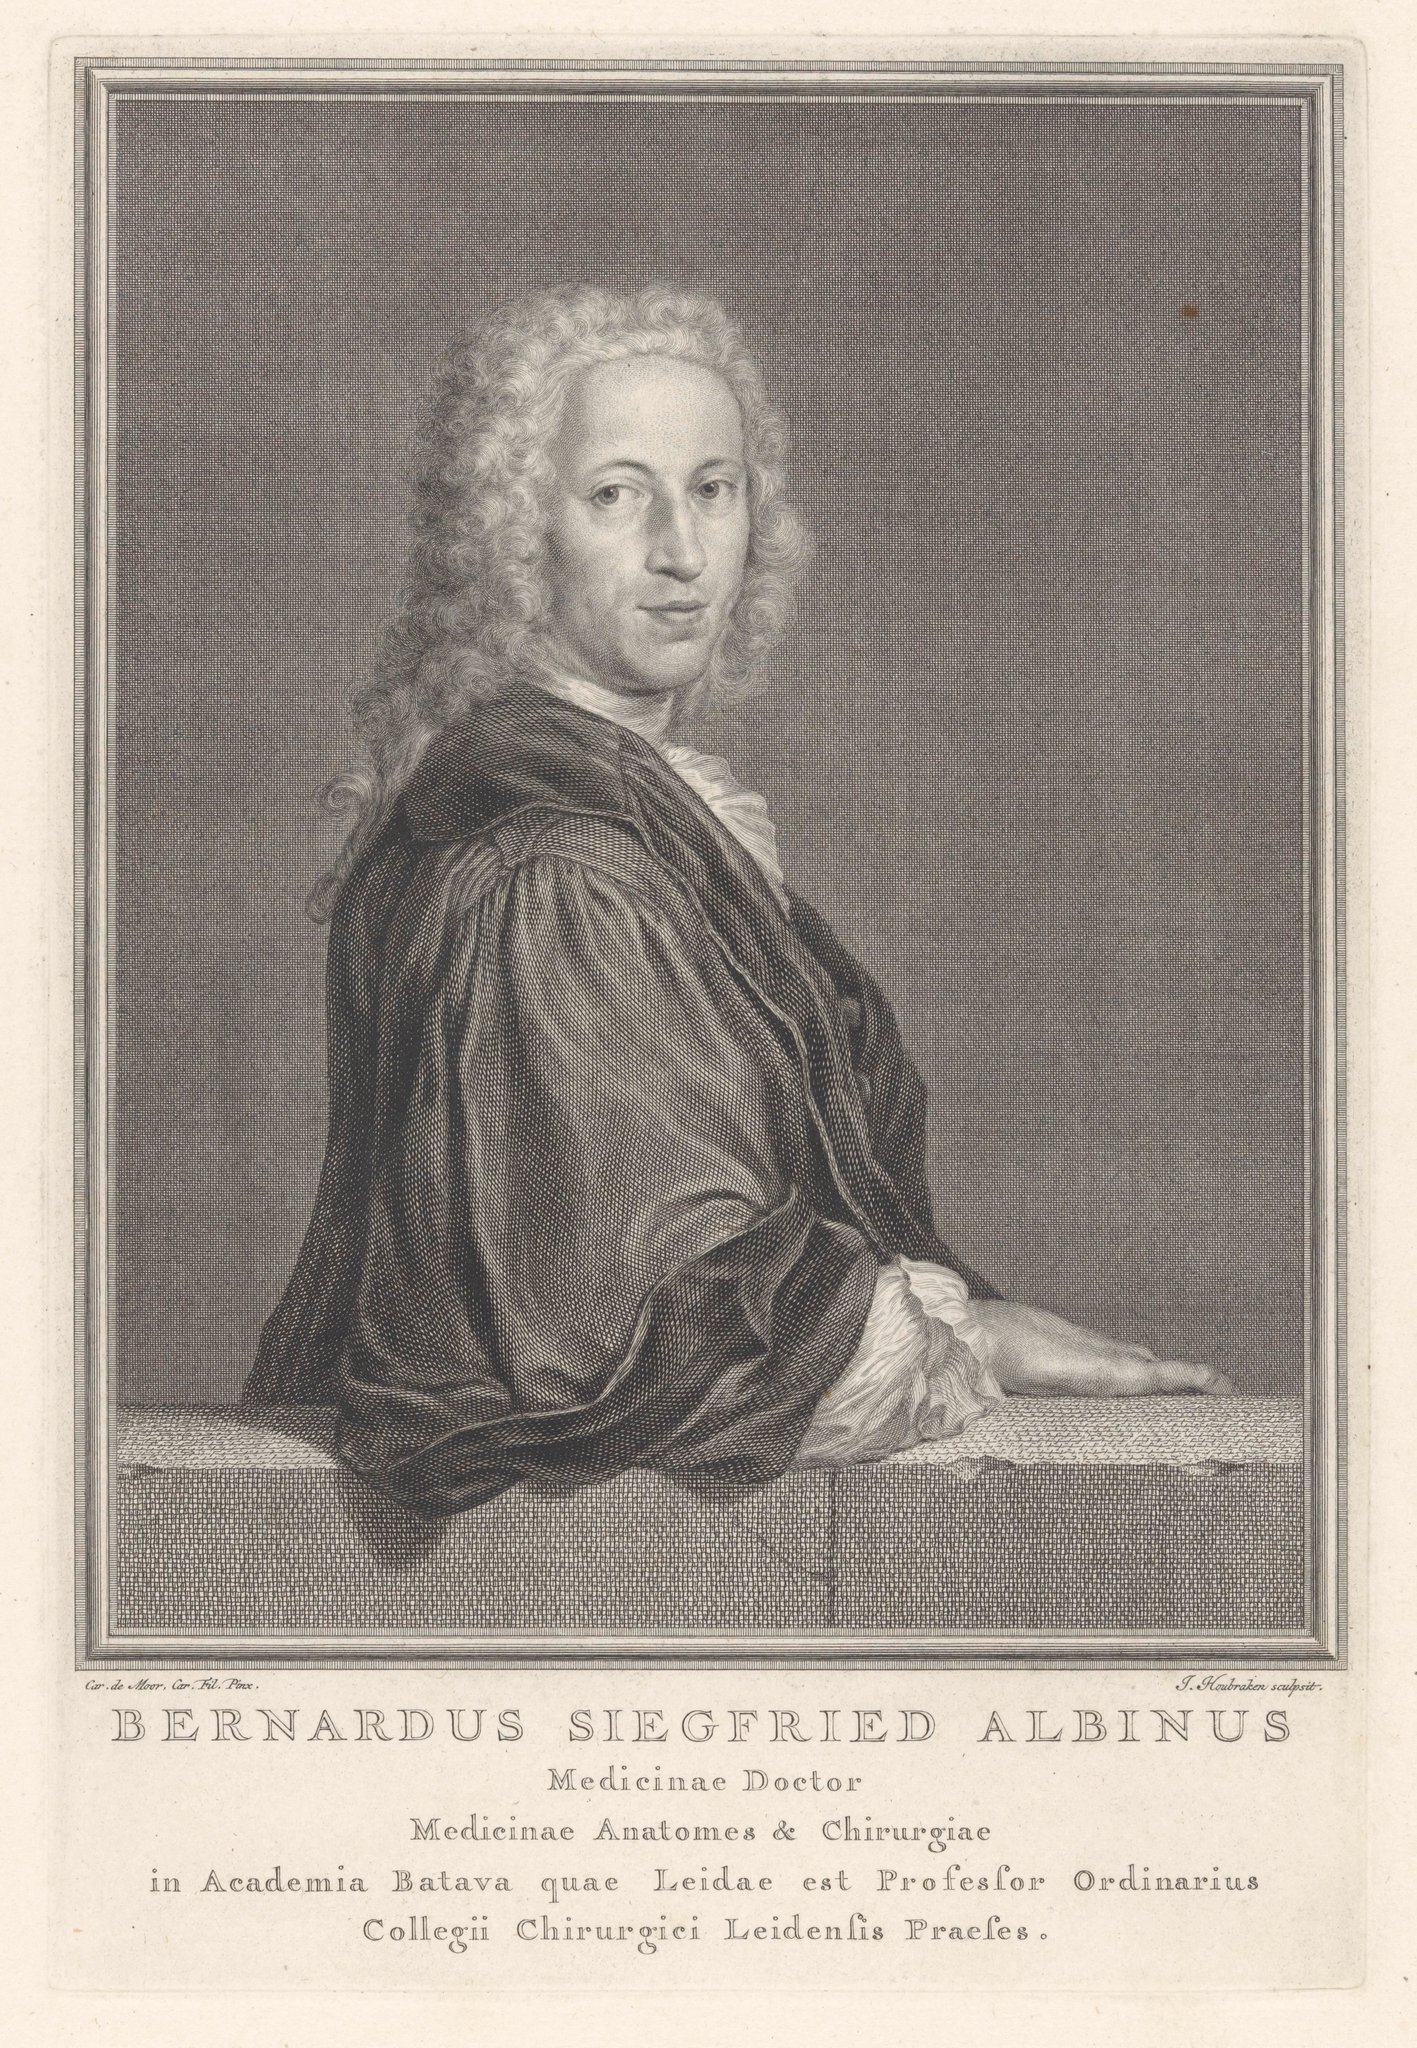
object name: print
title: Portret van Bernard Siegfried Albinus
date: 1721-1780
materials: paper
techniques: engraving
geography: amsterdam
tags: leiden, bernard siegfried albinus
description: Portret van Bernard Siegfried Albinus in een rechthoekige omlijsting. In de ondermarge zijn naam en vier regels Latijnse tekst.